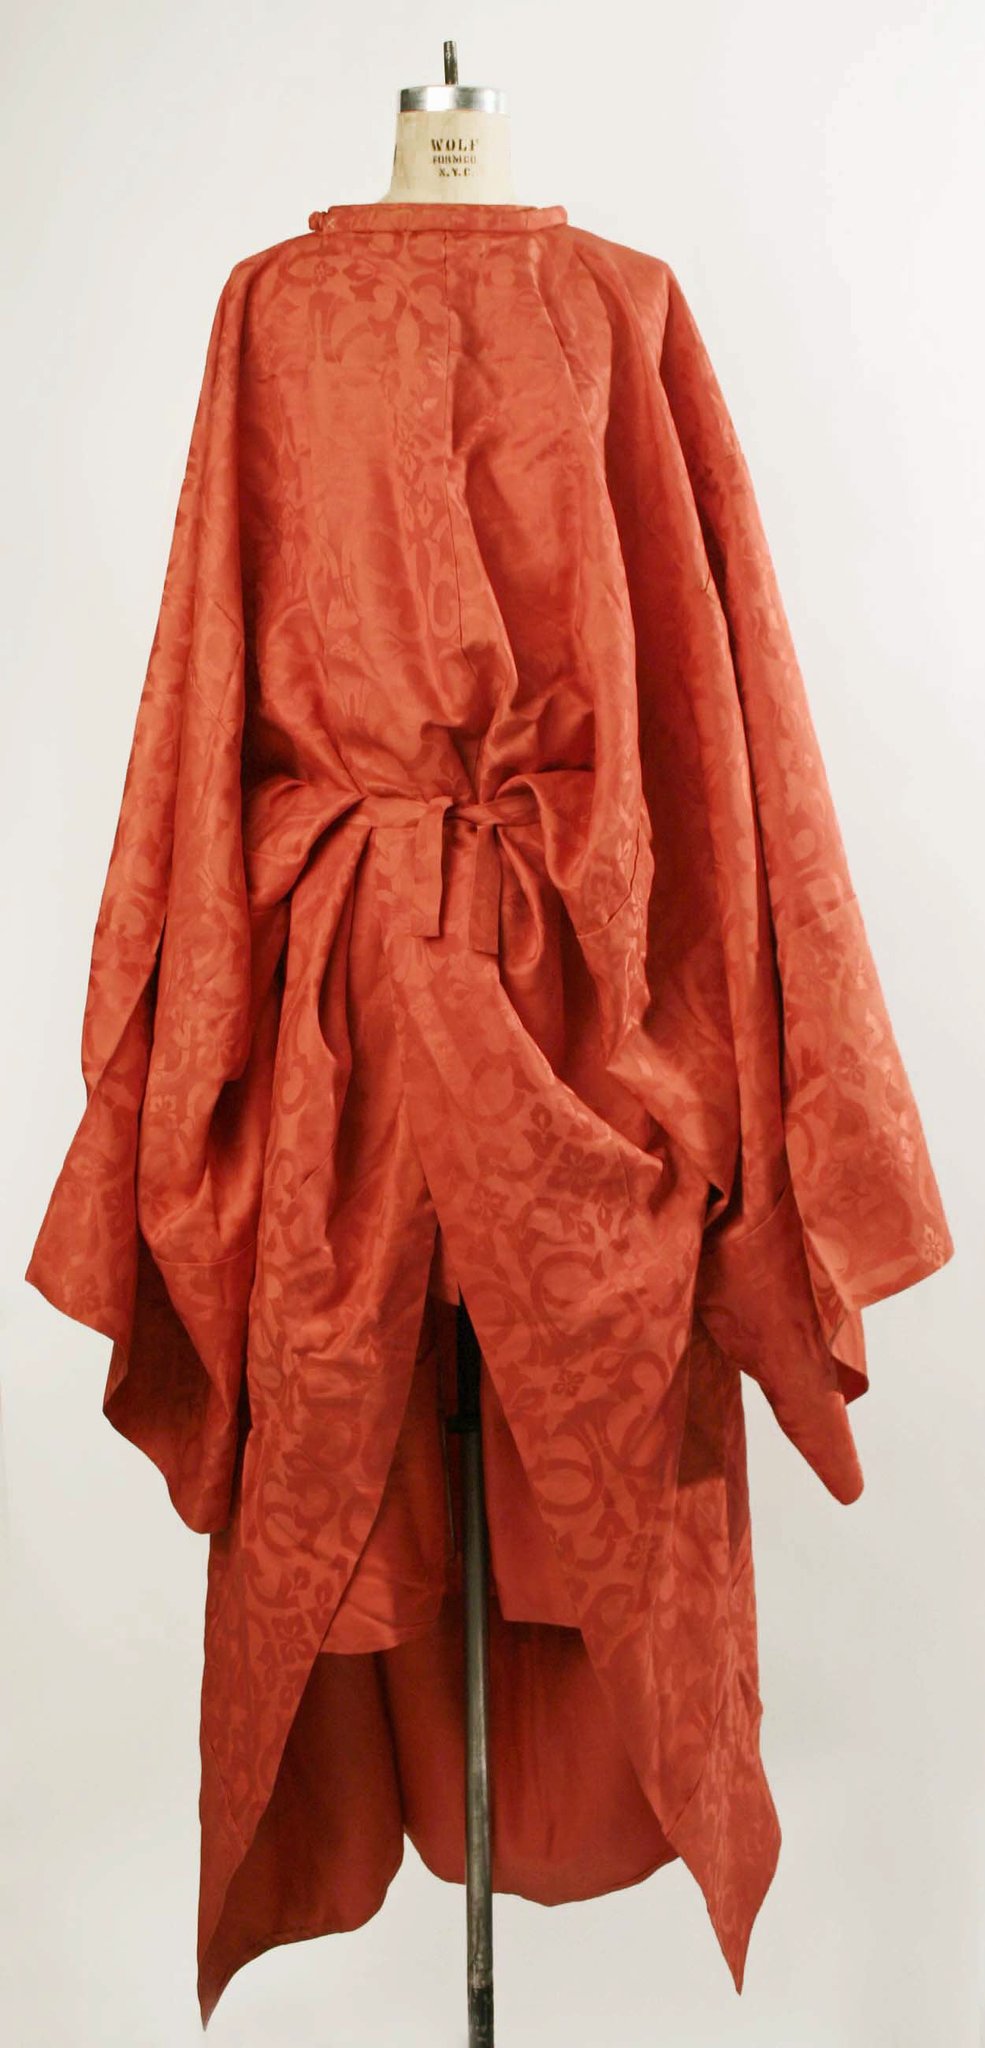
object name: ensemble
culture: japanese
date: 1895-1900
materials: silk